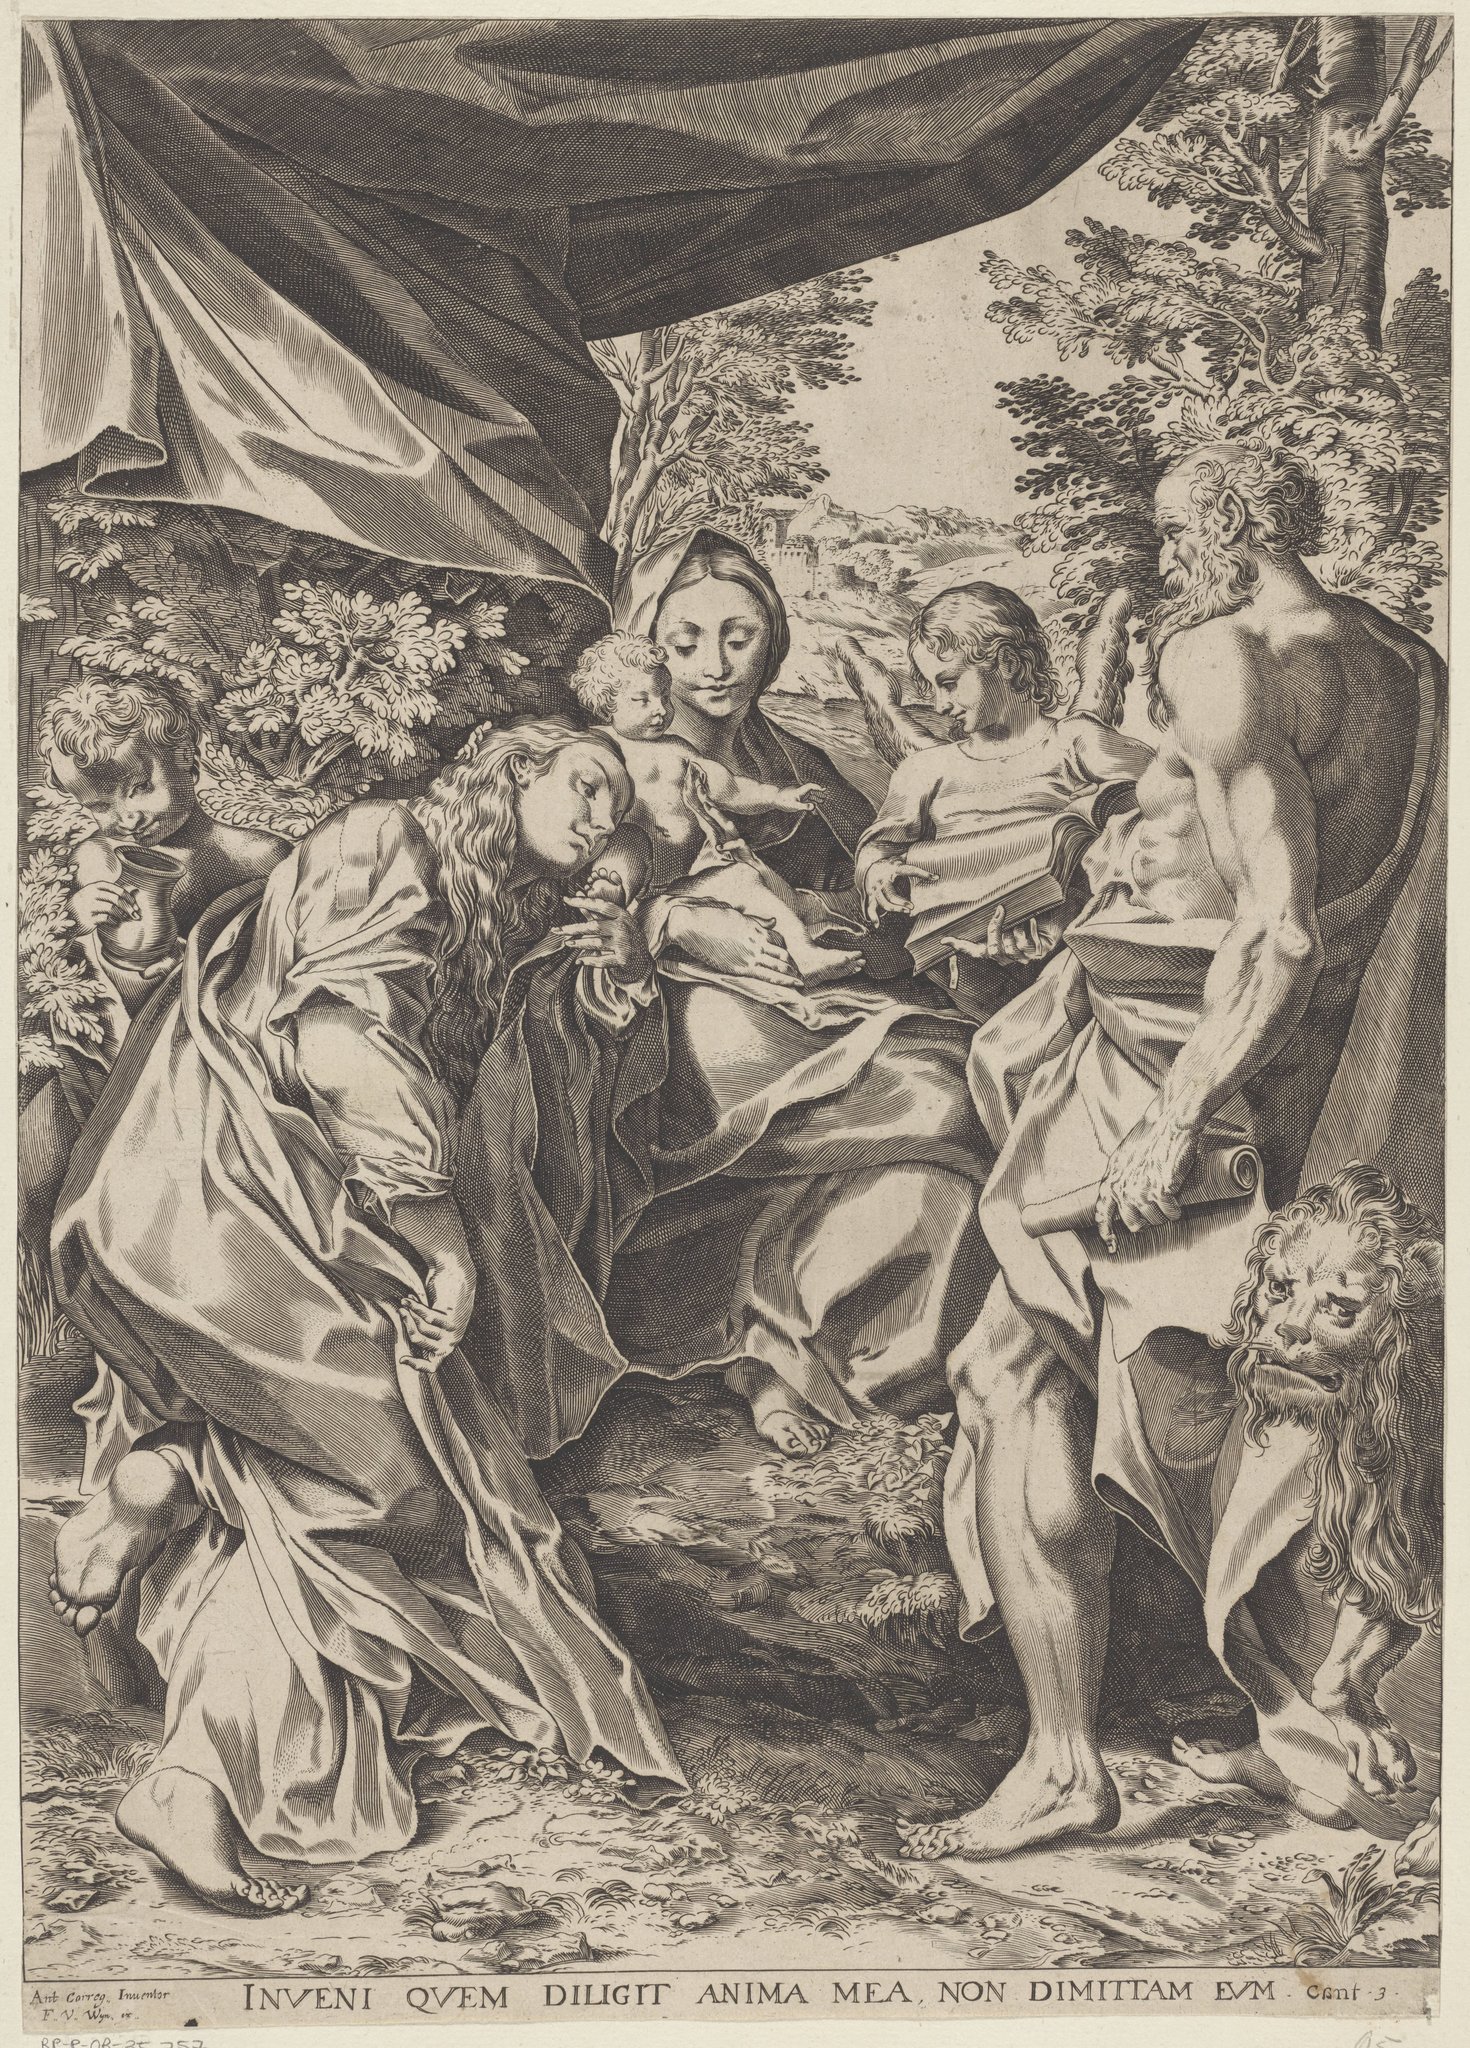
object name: print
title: Maria met Kind en de heilige Hieronymus en Maria Magdalena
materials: paper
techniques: engraving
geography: italy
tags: madonna accompanied by saint(s), the monk and hermit jerome (hieronymus); possible attributes: book, cardinal's hat, crucifix, hour-glass, lion, skull, stone, the penitent harlot mary magdalene; possible attributes: book (or scroll), crown, crown of thorns, crucifix, jar of ointment, mirror, musical instrument, palm-branch, rosary, scourge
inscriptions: collector's mark: Lugt 240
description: Het Christuskind zit bij Maria op schoot. Een engel toont hem een boek. Op de voorgrond links staat de heilige Hieronymus met een leeuw. Rechts knielt de heilige Maria Magdalena en streelt met haar wang langs het been van Christus. Rechts een kleine jongen met een zalfpot.